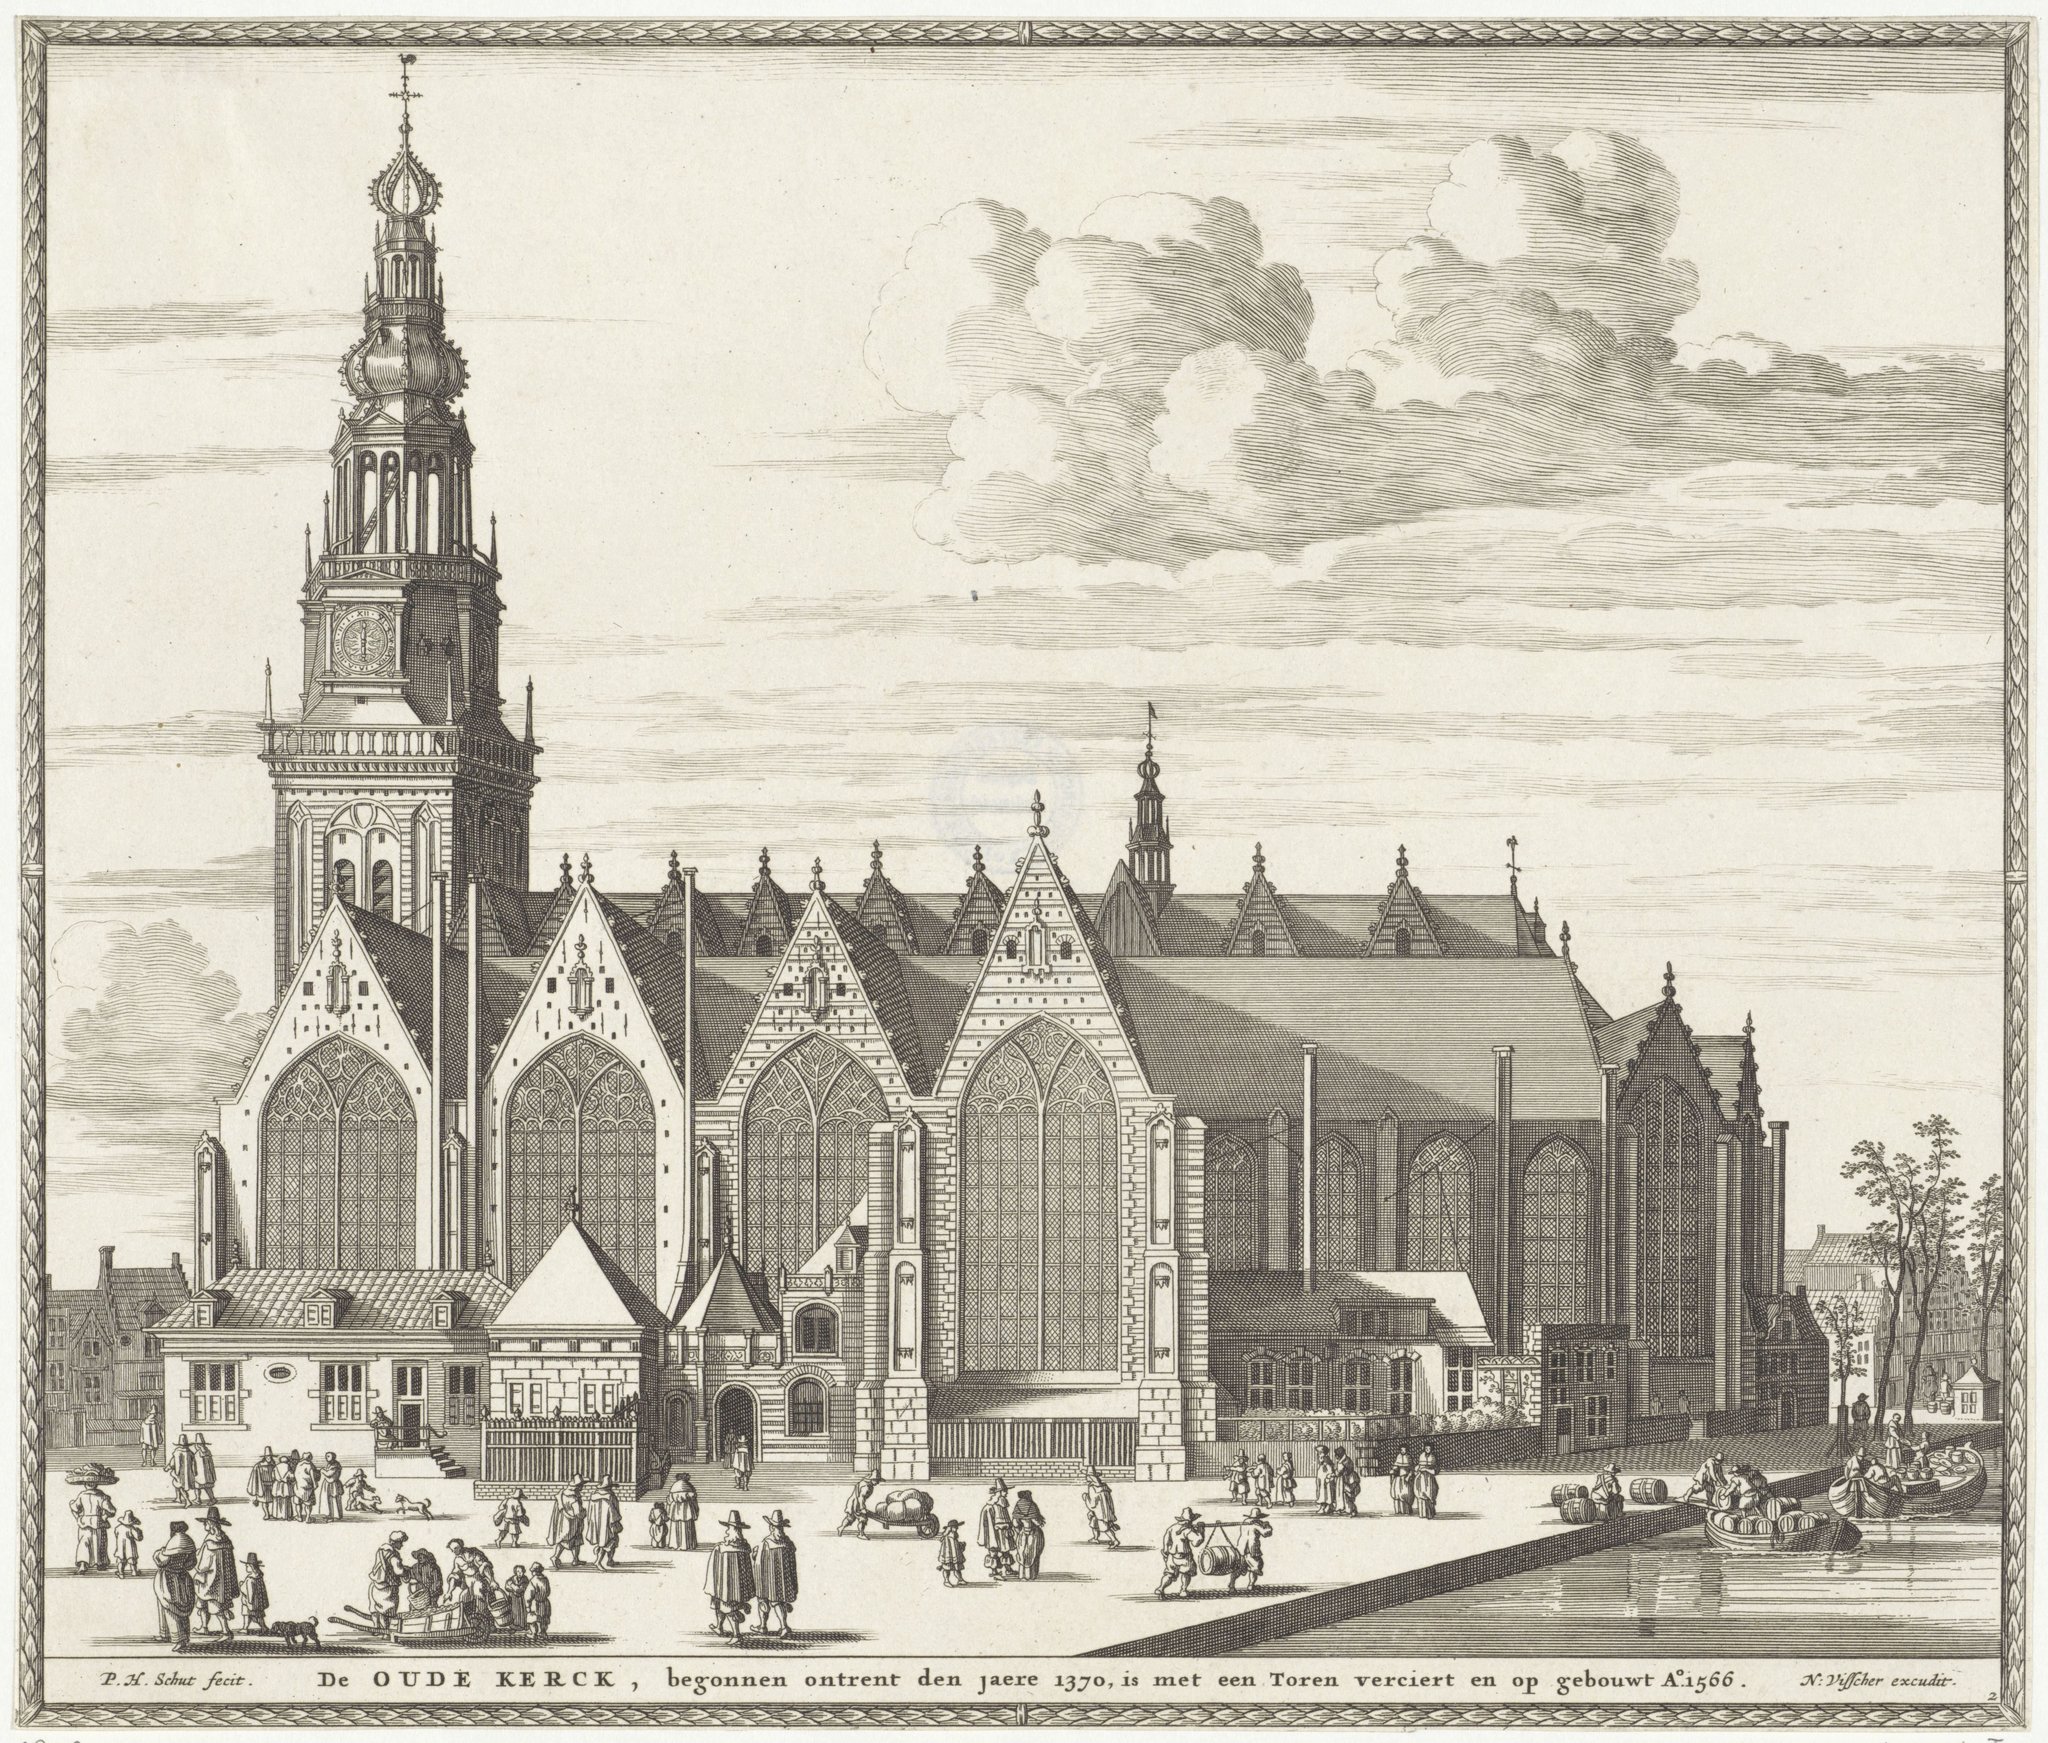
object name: print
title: Acht gebouwen in Amsterdam (Schut / Visscher)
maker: pieter hendricksz. schut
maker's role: print maker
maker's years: 1618-1660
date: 1662-1720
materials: paper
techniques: engraving, etching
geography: amsterdam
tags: church (exterior), street (+ city(-scape) with figures, staffage)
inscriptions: collector's mark: Lugt 1618, collector's mark: Lugt 2228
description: Ook uitgegeven als onderdeel van sierrand van een wandkaart van Amsterdam, zie RP-P-AO-20-45. Latere staat uitgegeven door Covens & Mortier.